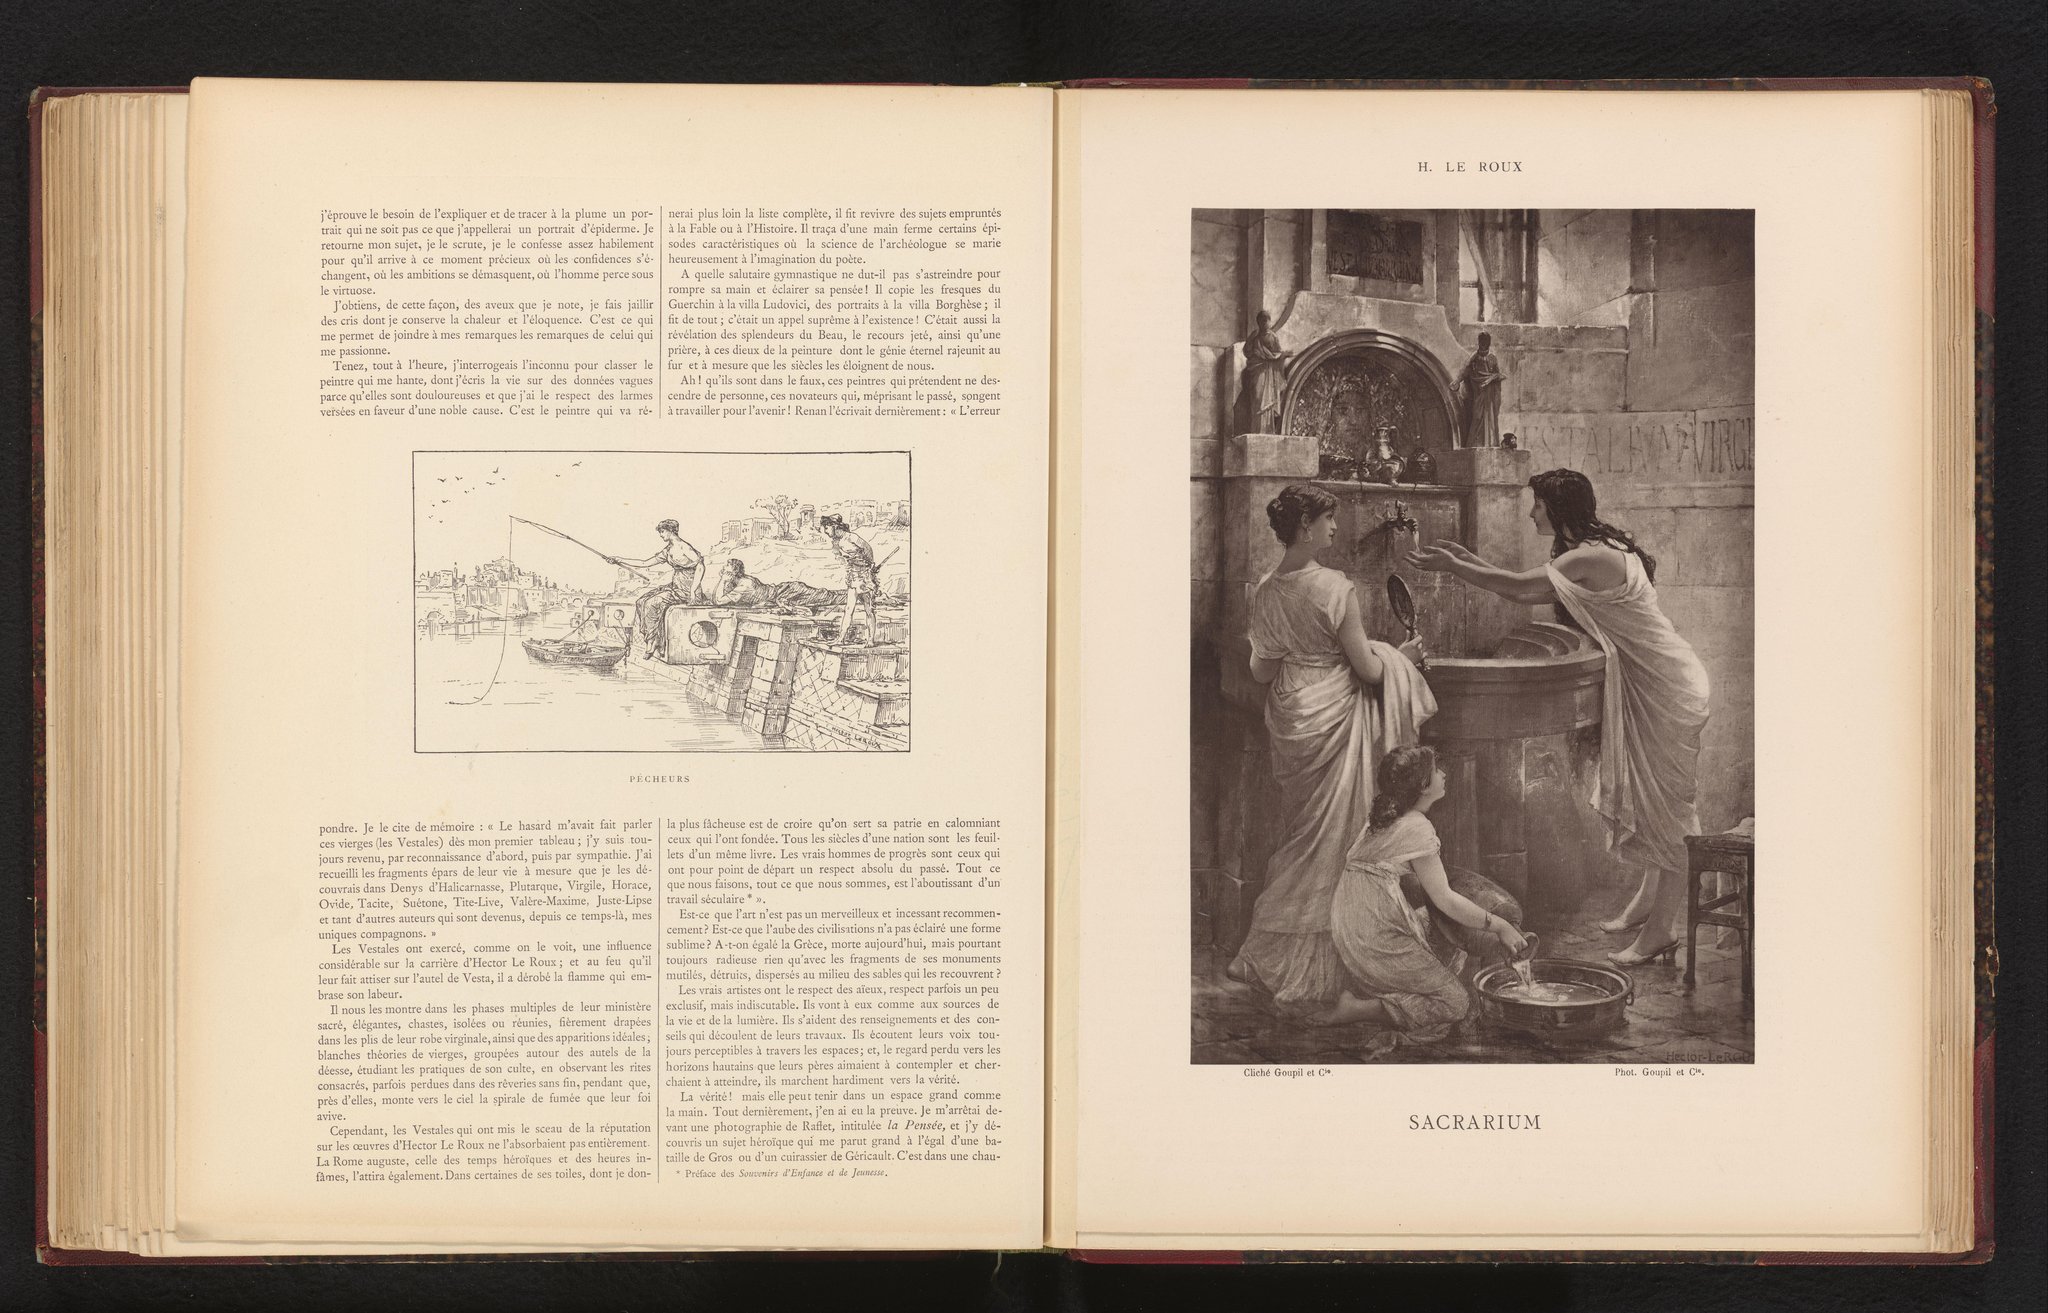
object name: photomechanical print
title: Sacrarium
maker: louis héctor leroux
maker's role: painter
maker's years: 1829-1900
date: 1878-1883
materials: paper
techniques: woodburytype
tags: jug and basin; wash-basin